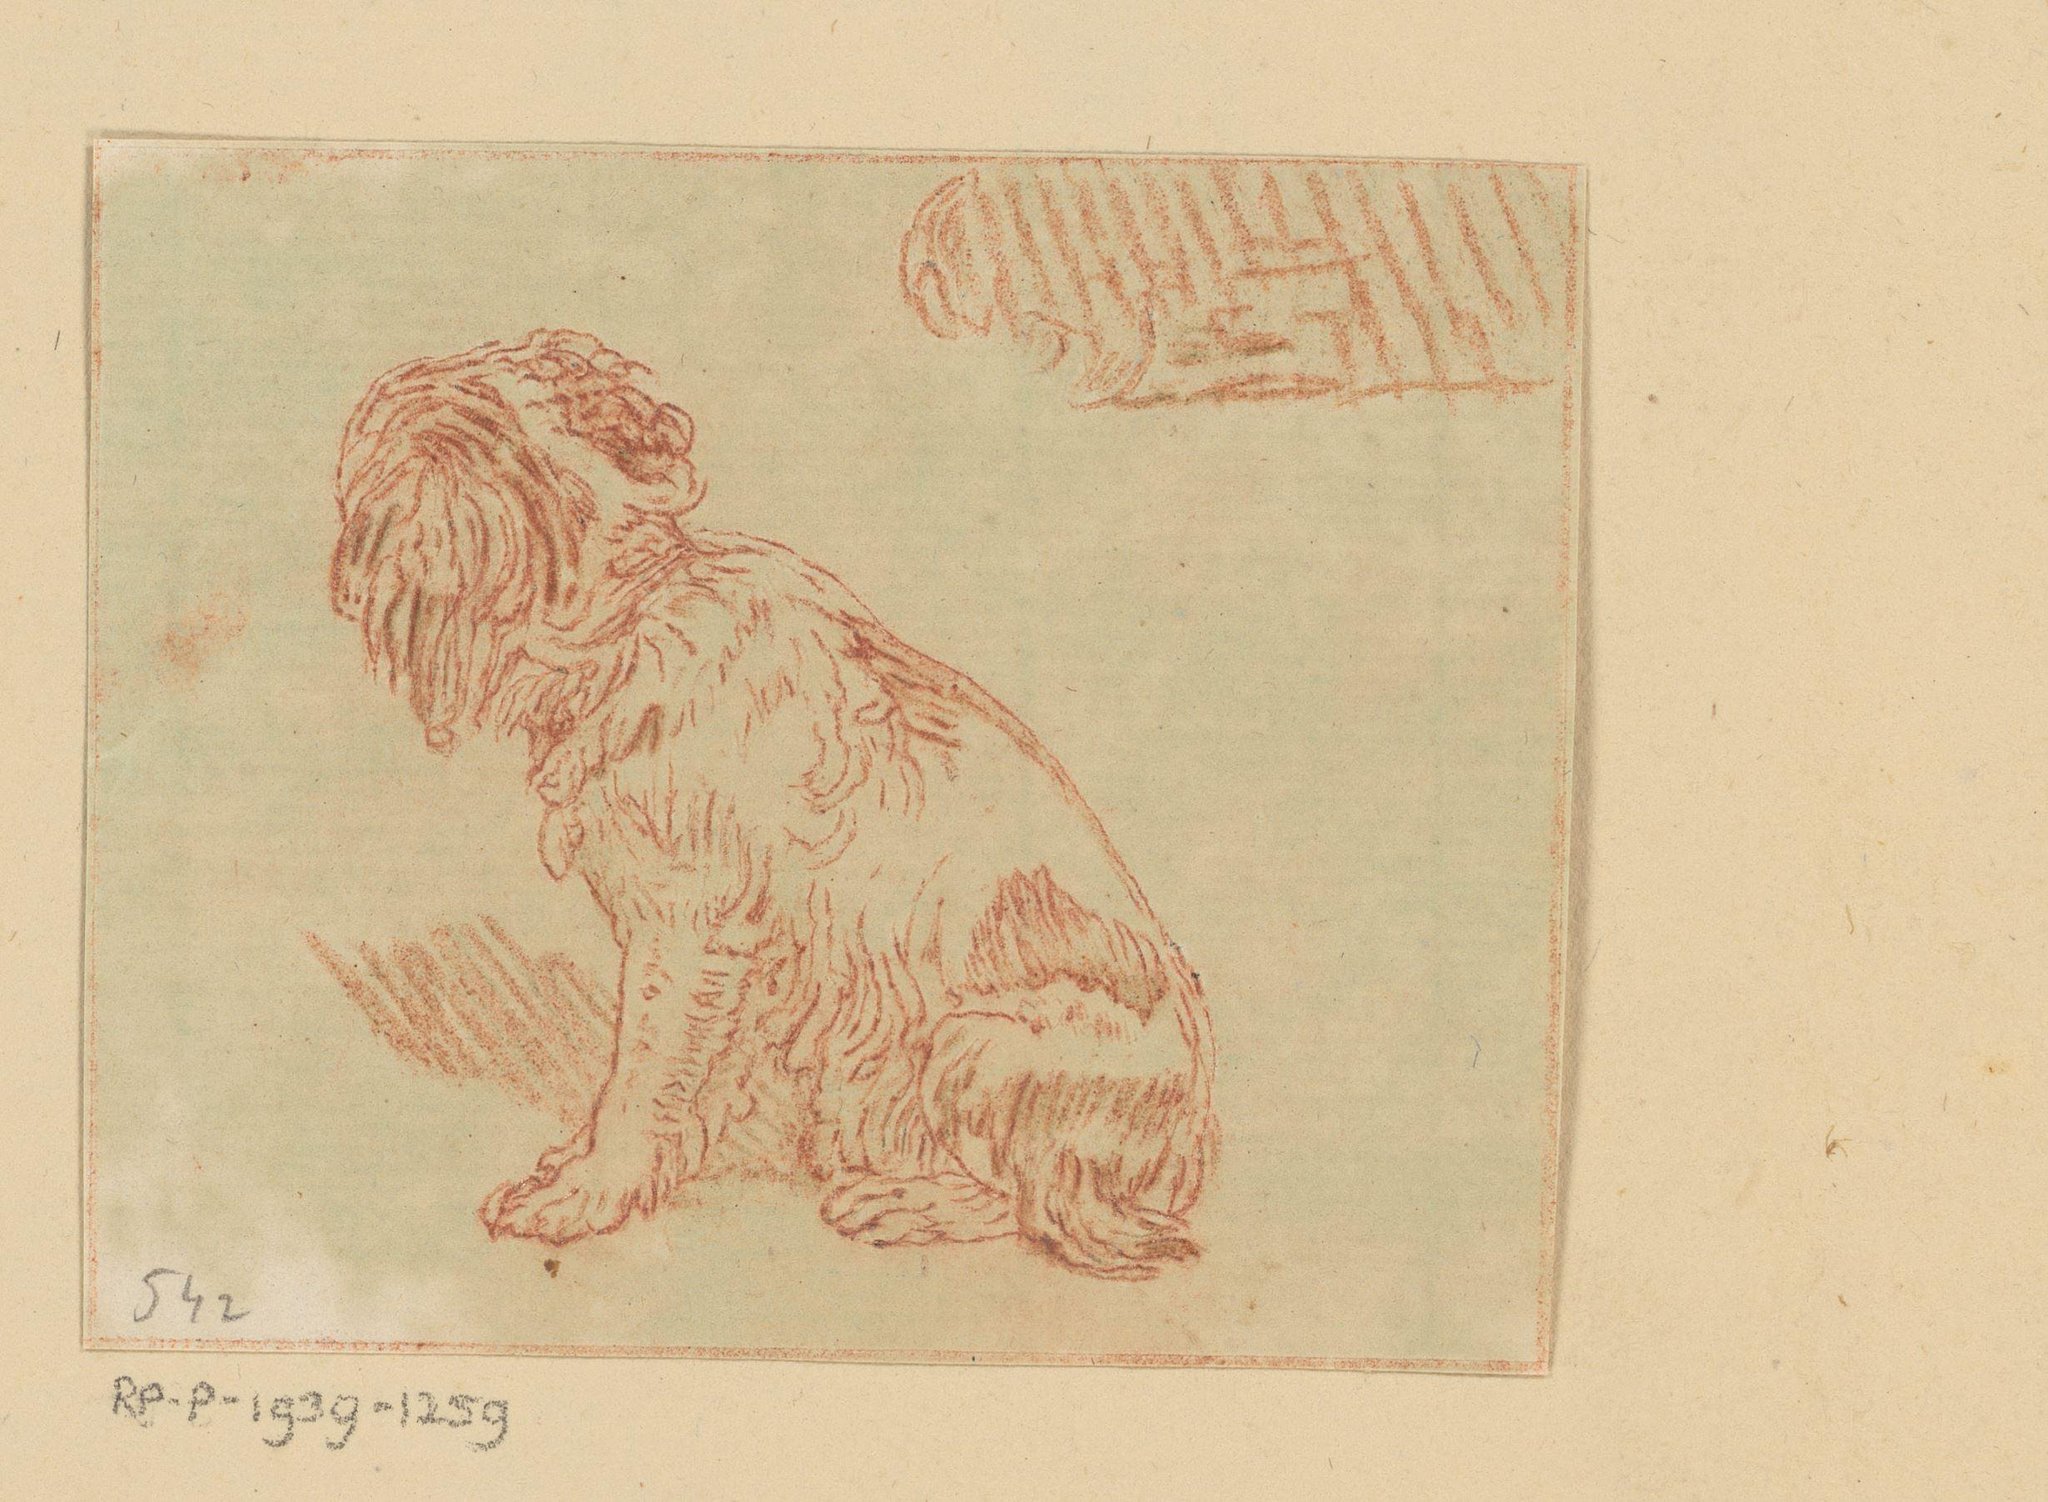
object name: drawing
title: Zittende hond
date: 1777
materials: chalk, paper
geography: amsterdam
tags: dog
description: Over de doordruktekeningen van Ploos van Amstel zie LNP, p. 201.